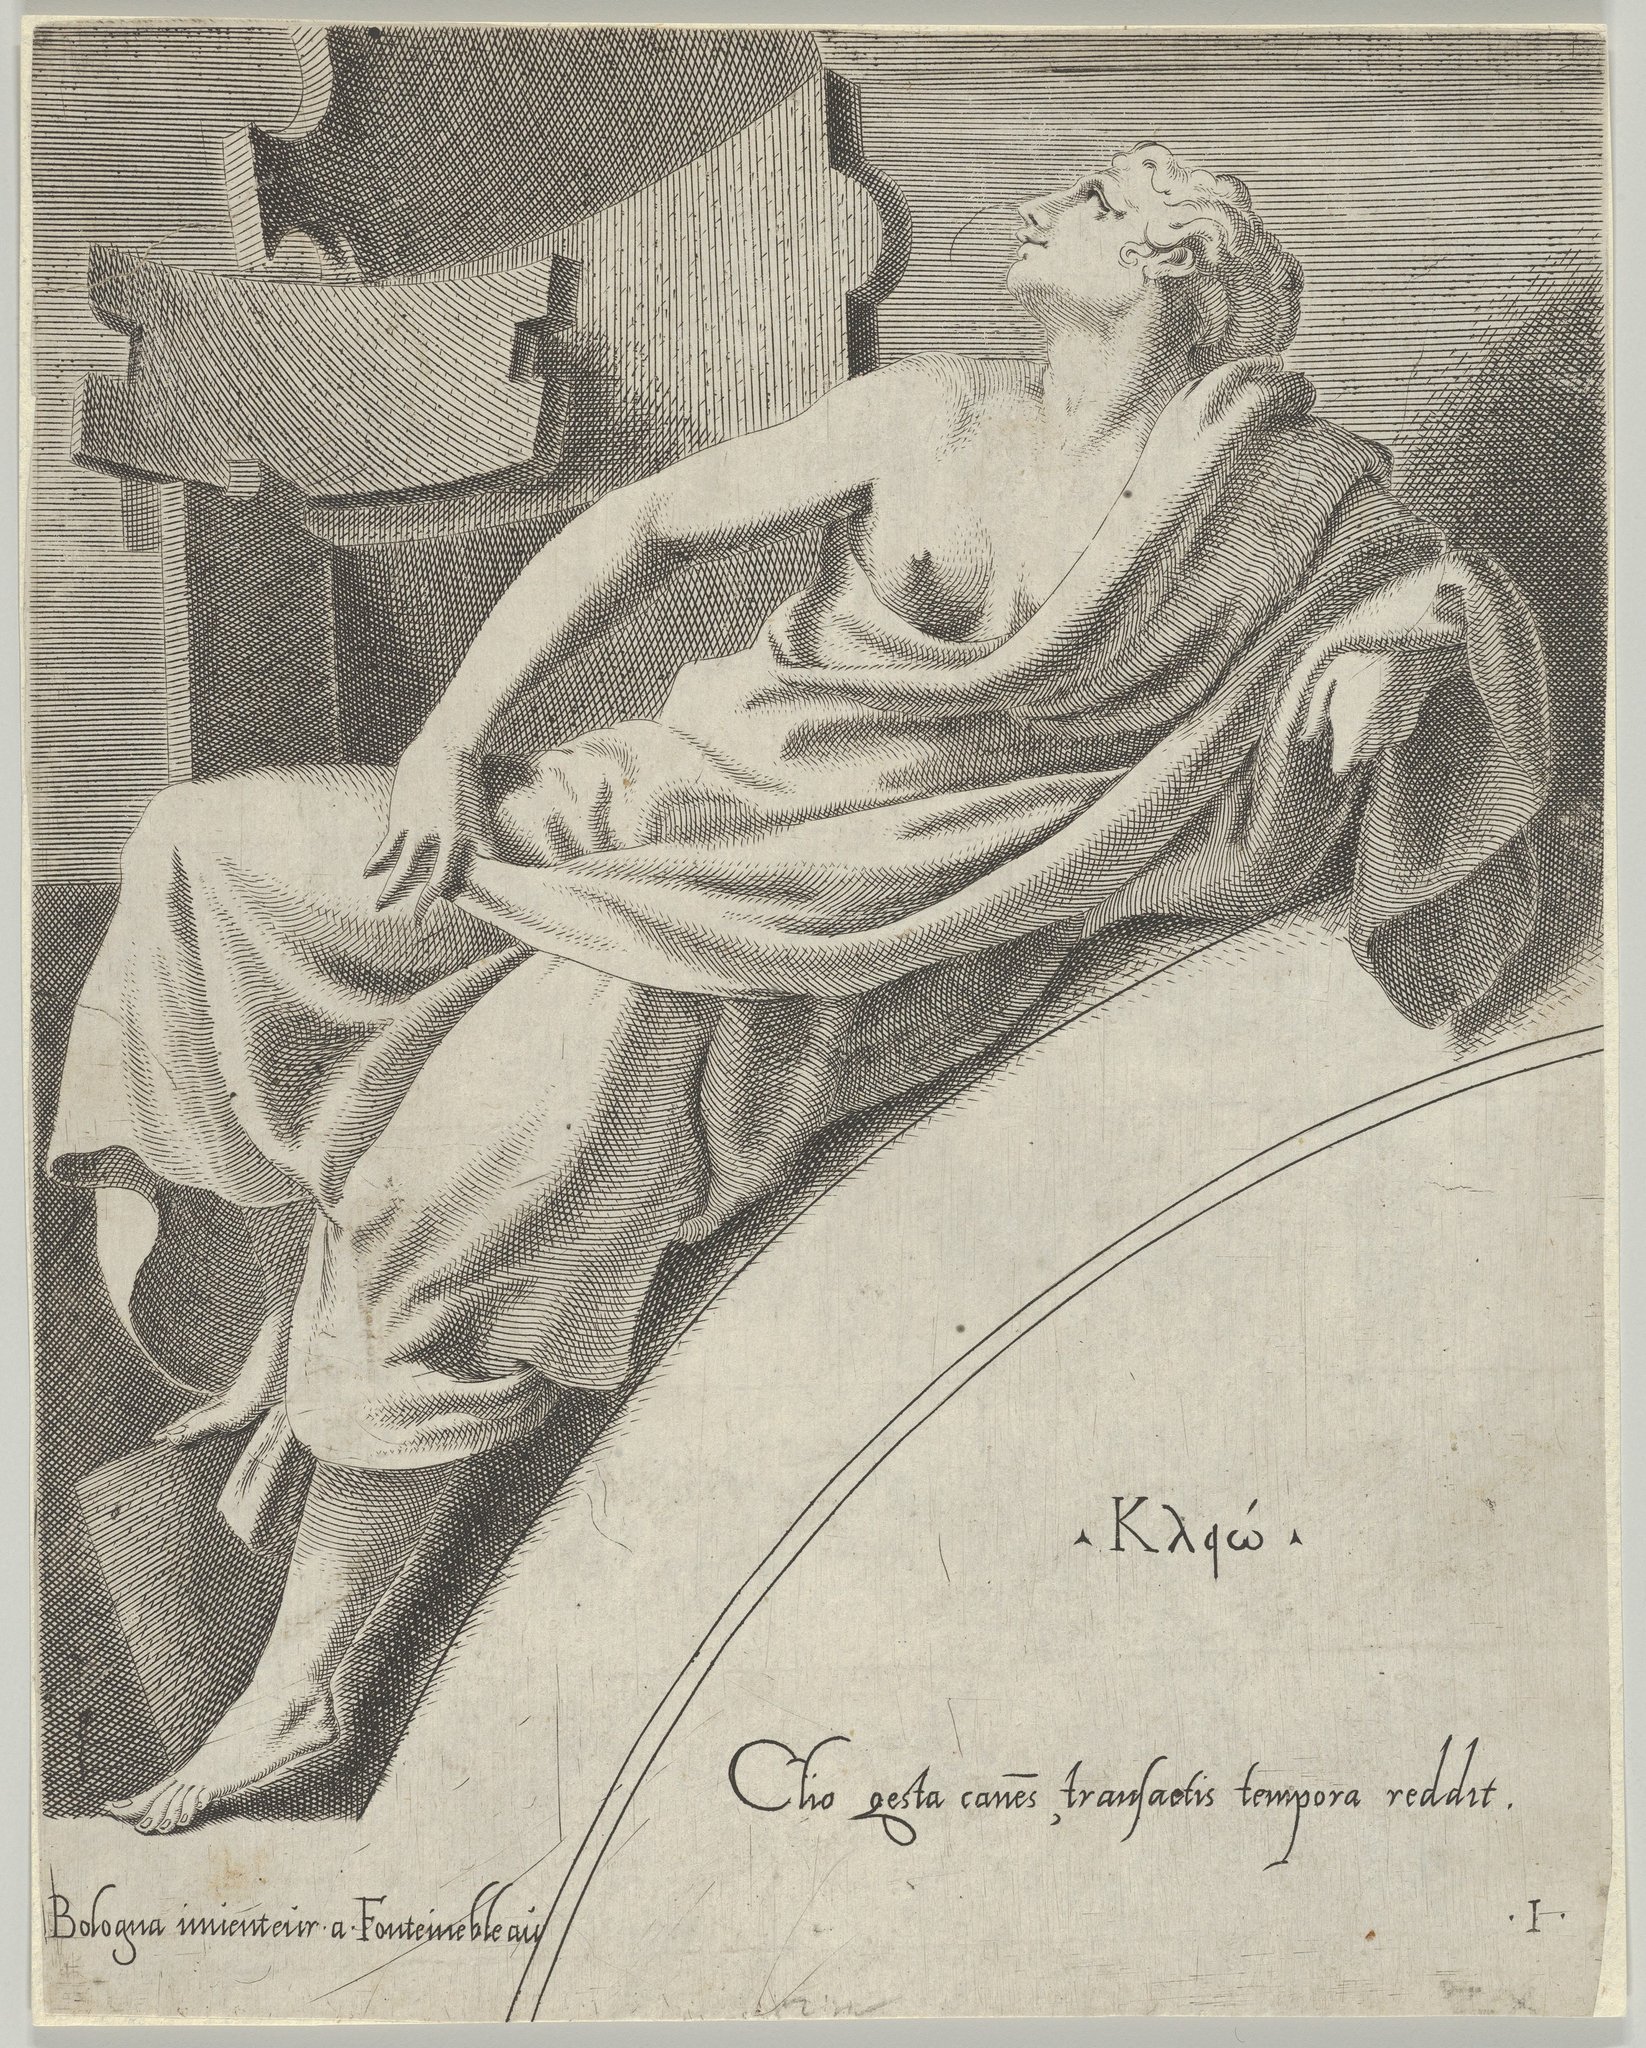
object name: print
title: Clio, from "The Muses and the Three Goddesses"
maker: anonymous, french-italian, 17th century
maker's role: artist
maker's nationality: french italian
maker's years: 1600-1700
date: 1540-1545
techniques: engraving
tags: female nudes